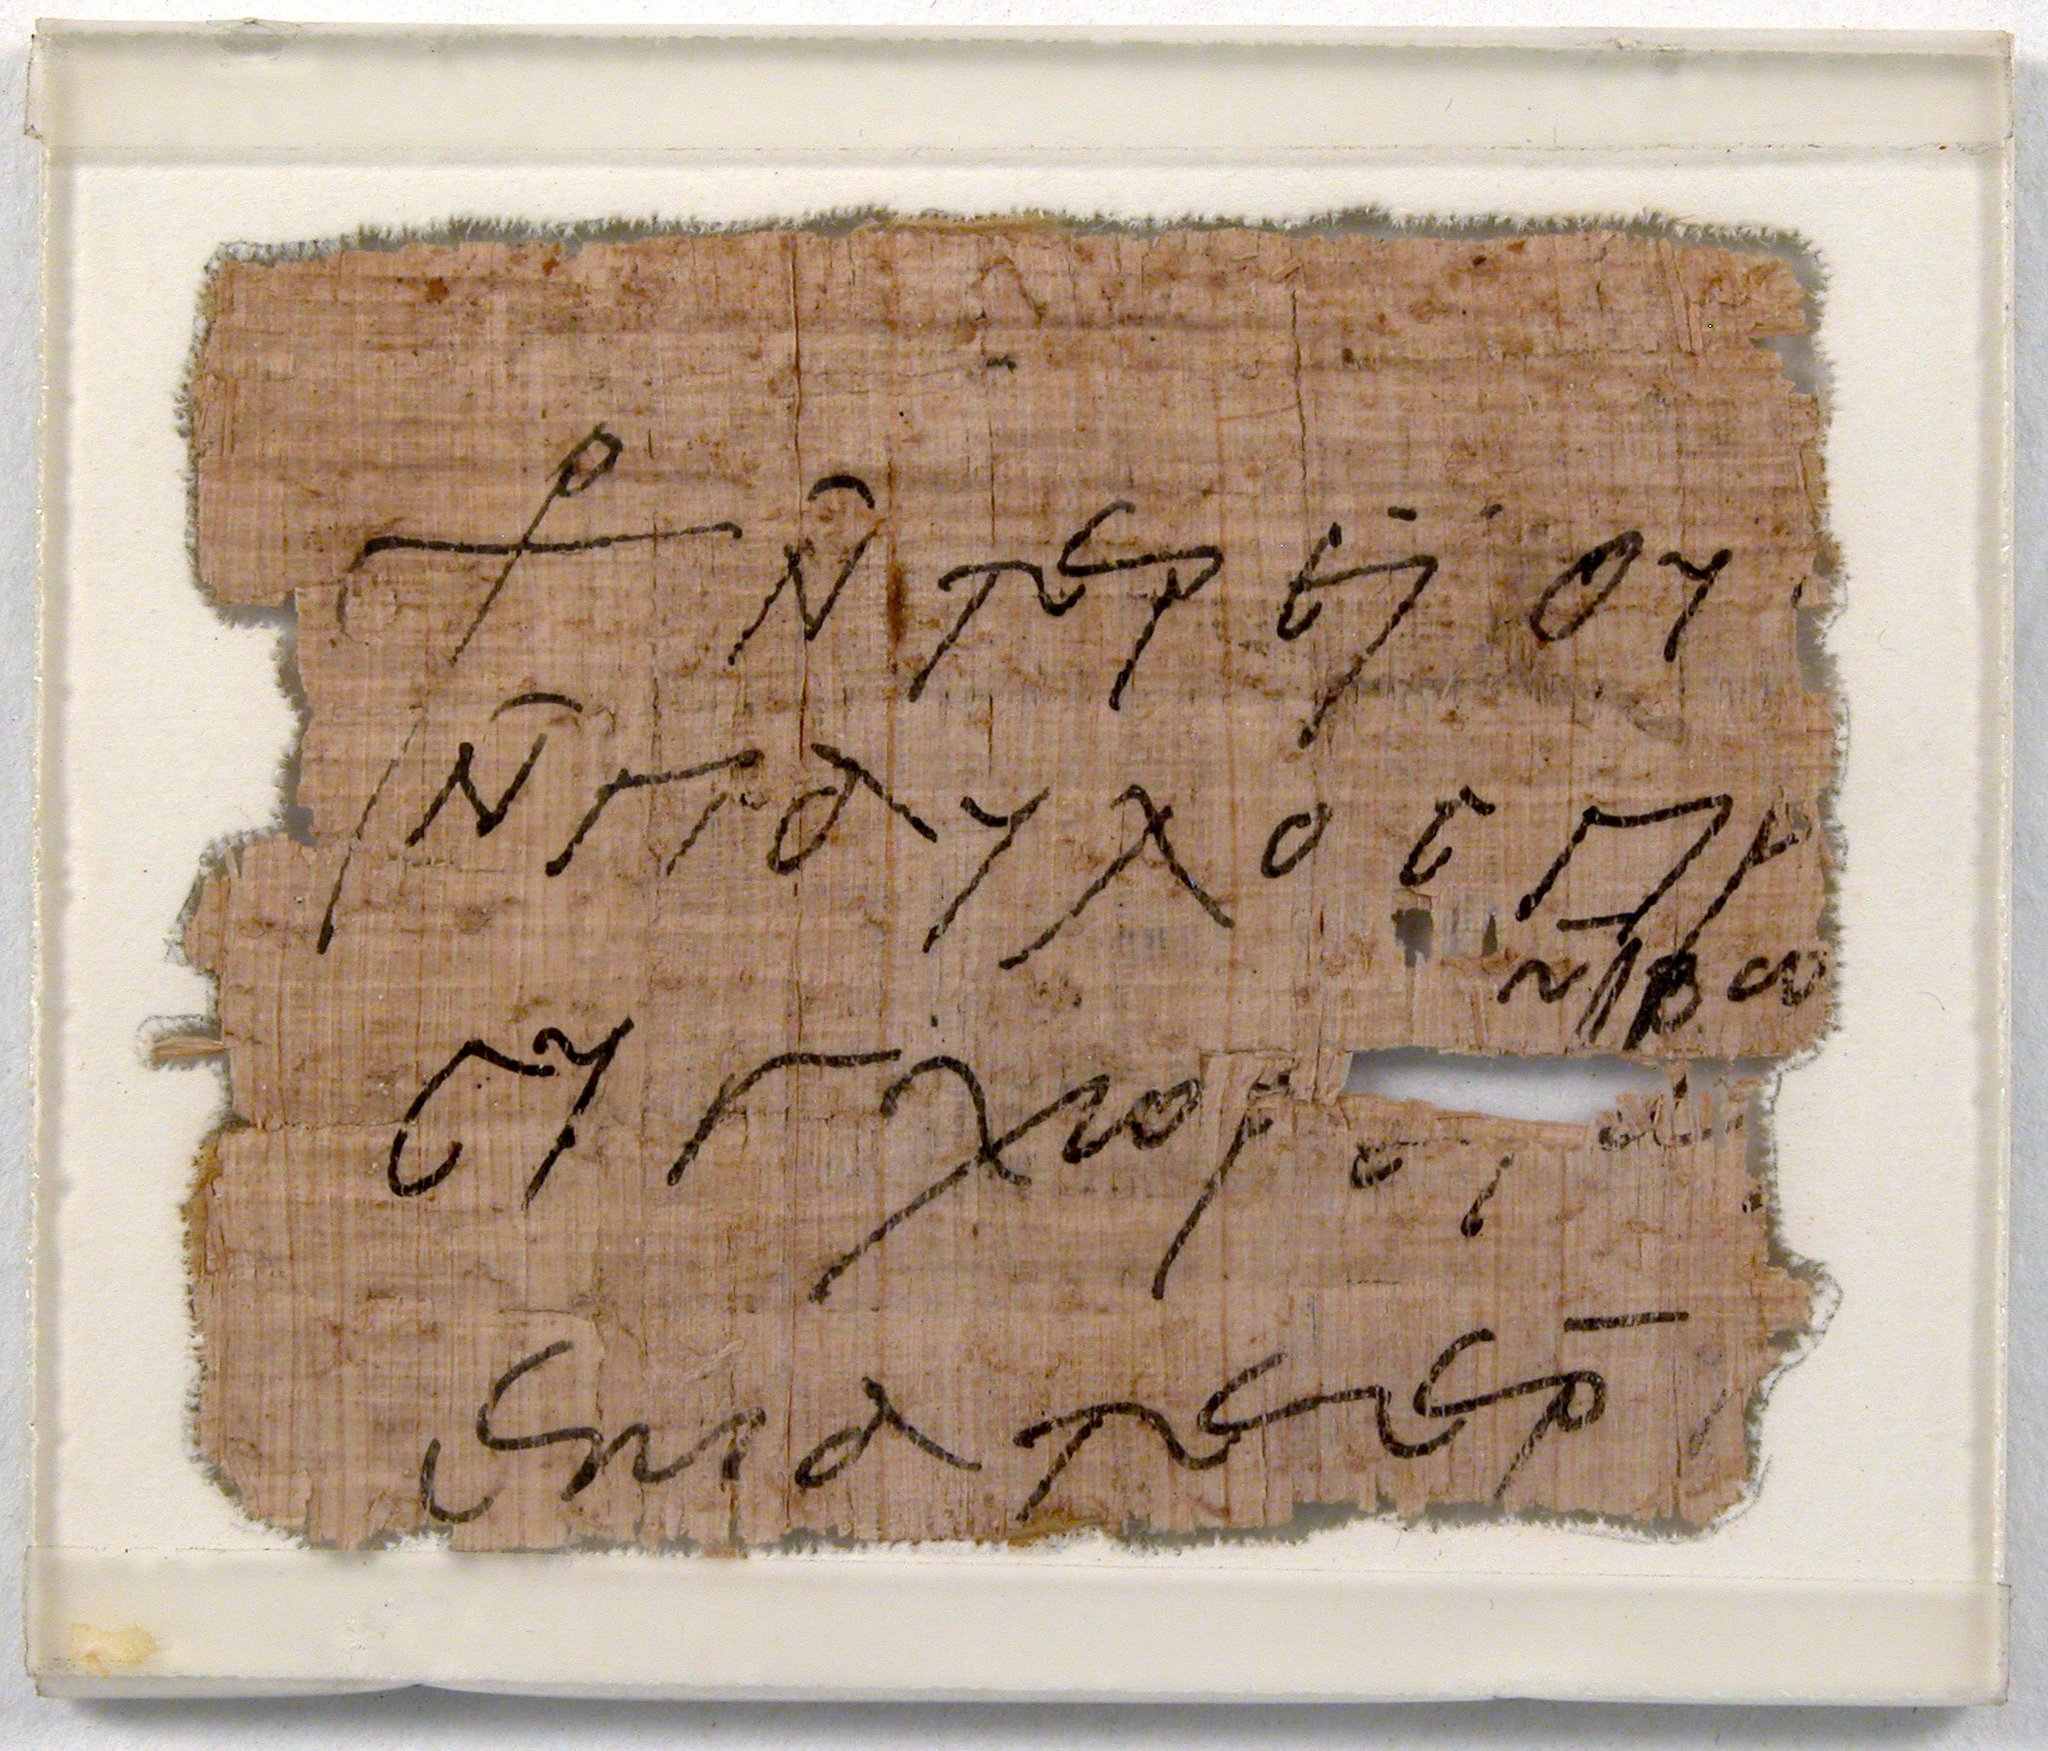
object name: fragment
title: Papyrus Fragment of a Letter from Joinistus to Epiphanius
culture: coptic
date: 601-700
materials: ink, papyrus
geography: egypt